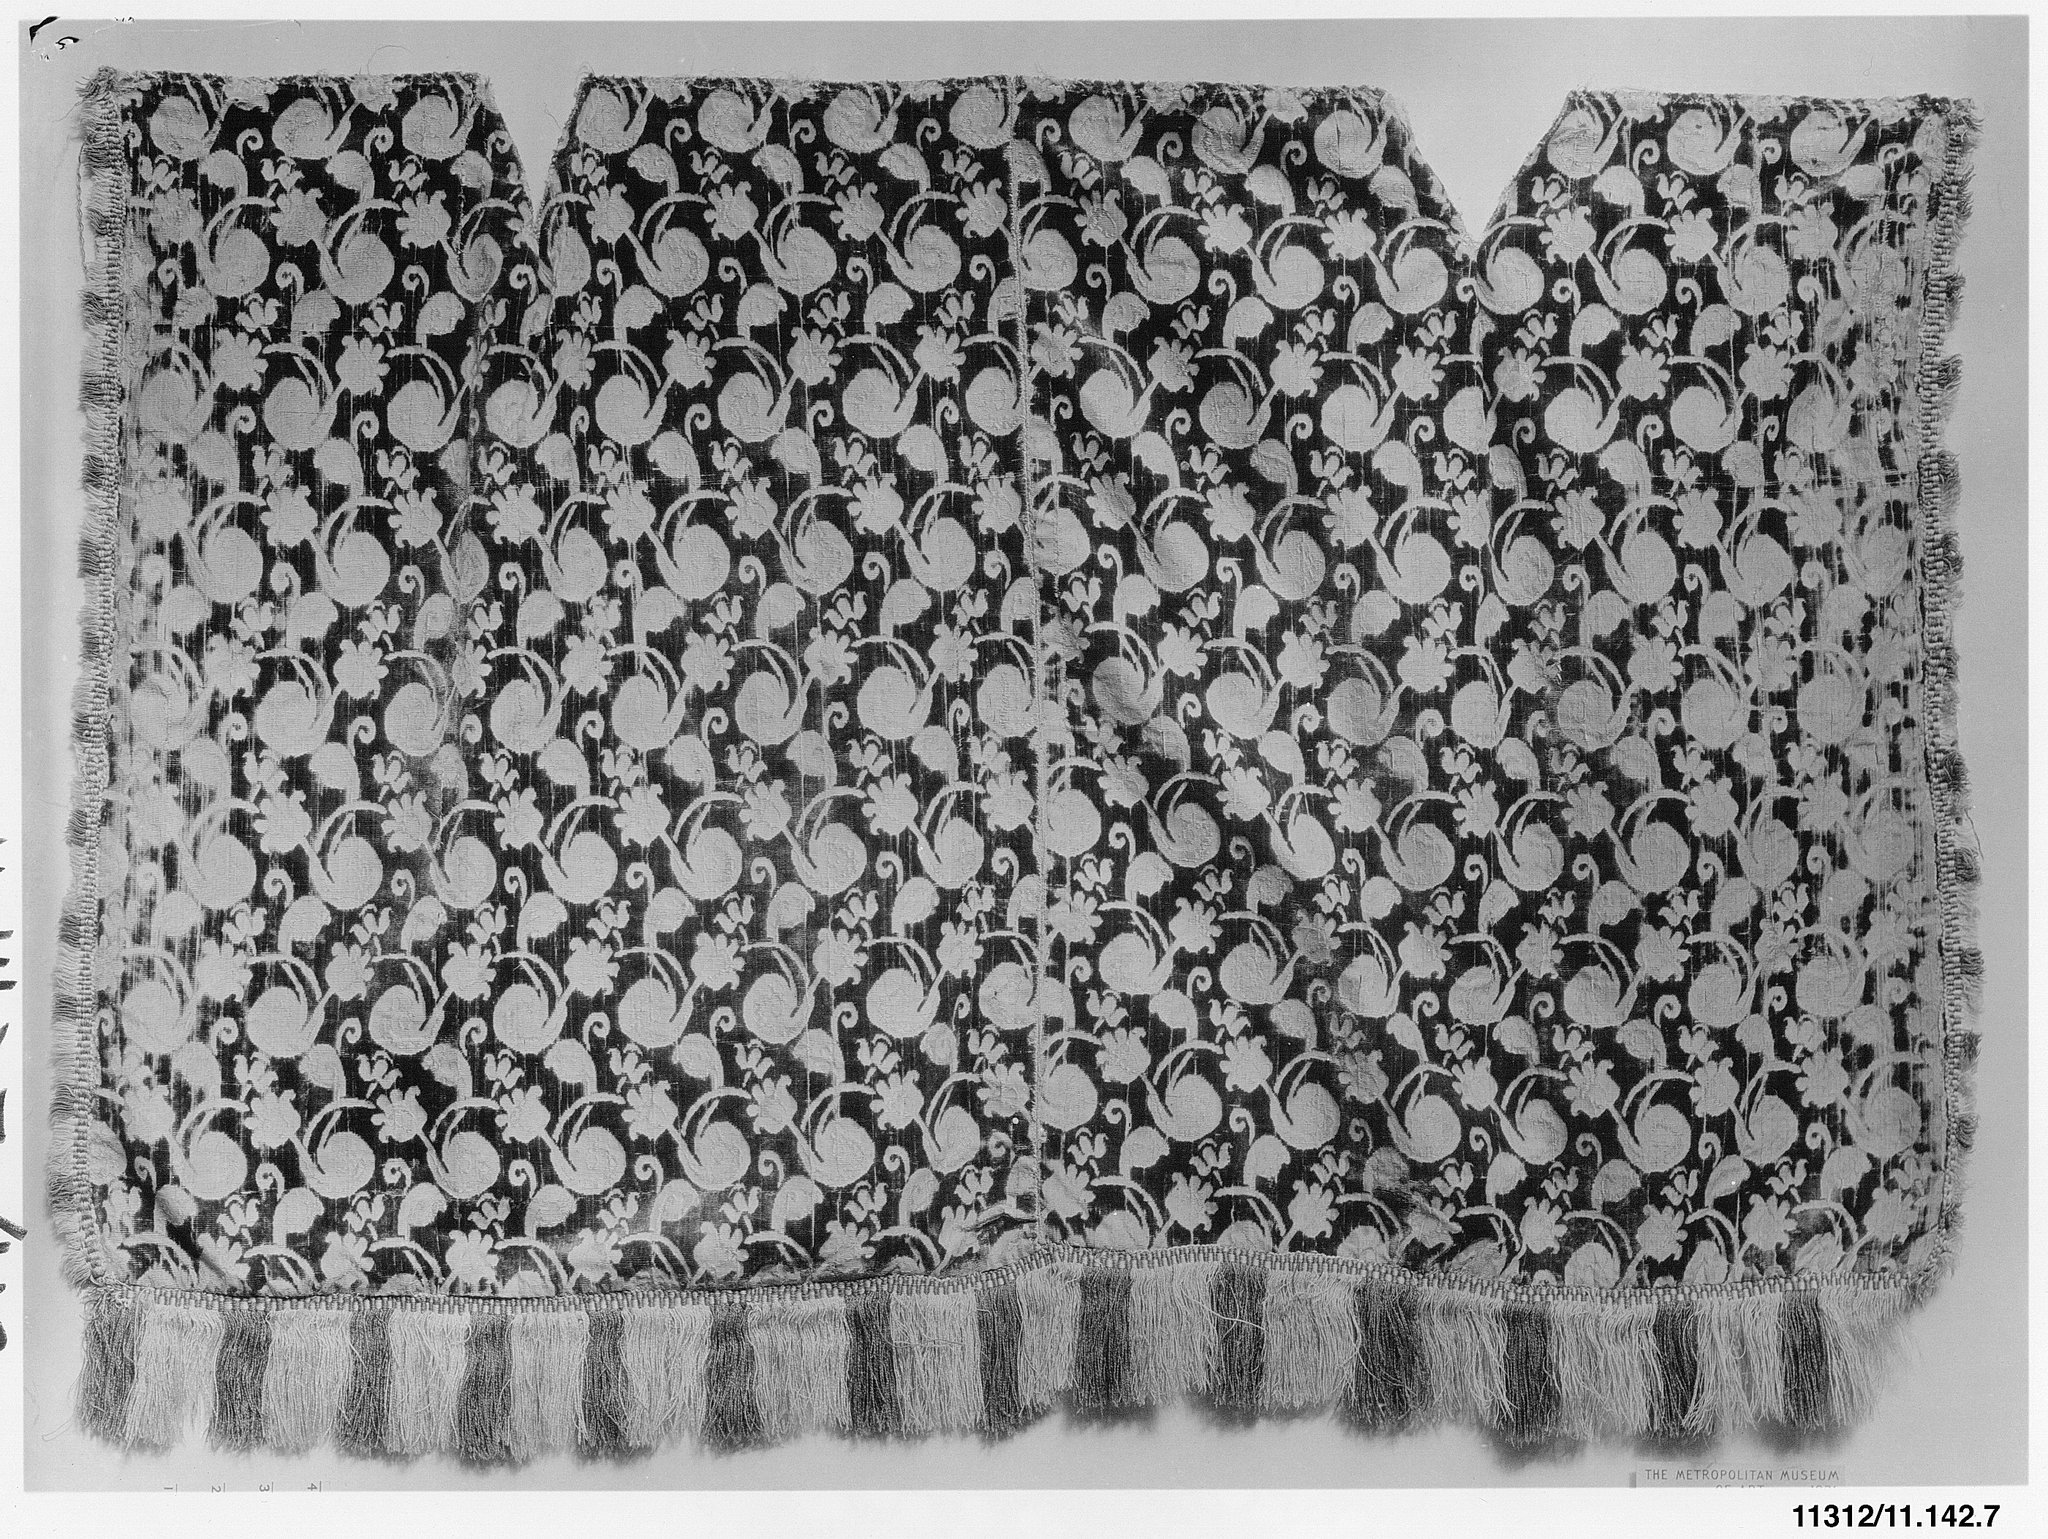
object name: piece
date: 1567-1633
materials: silk